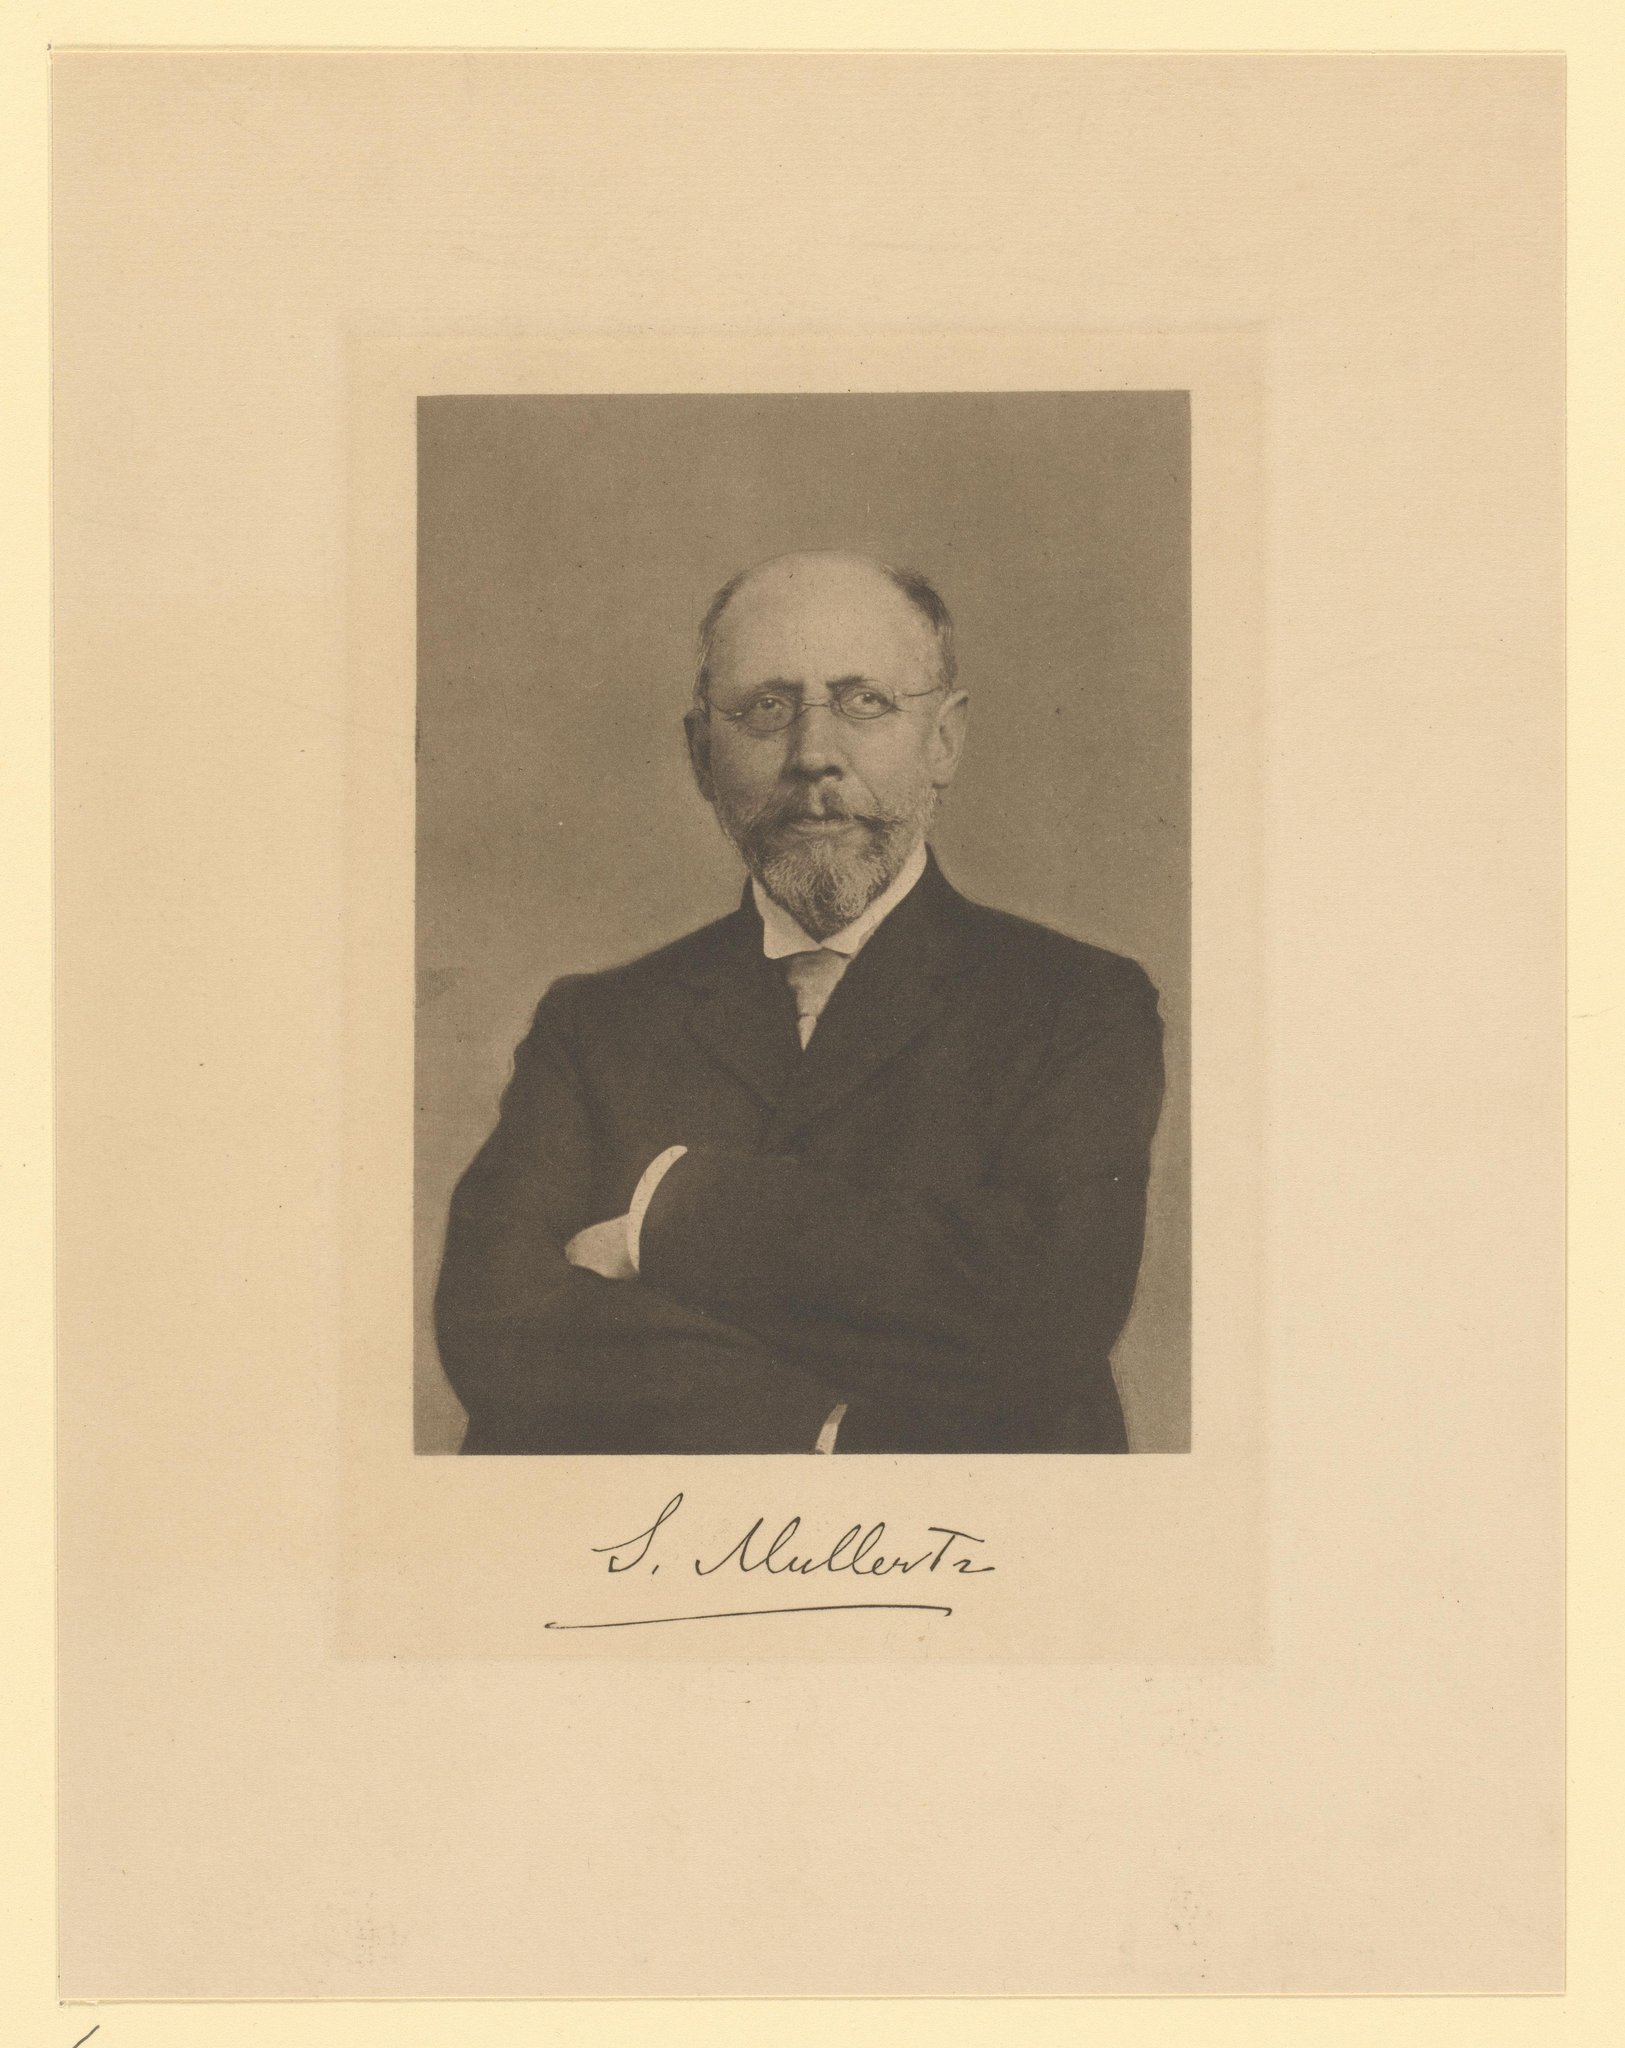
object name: photomechanical print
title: Portret van Samuel Muller Fz.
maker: Anonymous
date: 1900-1910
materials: paper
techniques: photoaquatint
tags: samuel muller (1848-1922), historical persons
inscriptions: inscription: ‘S. Muller Fz’